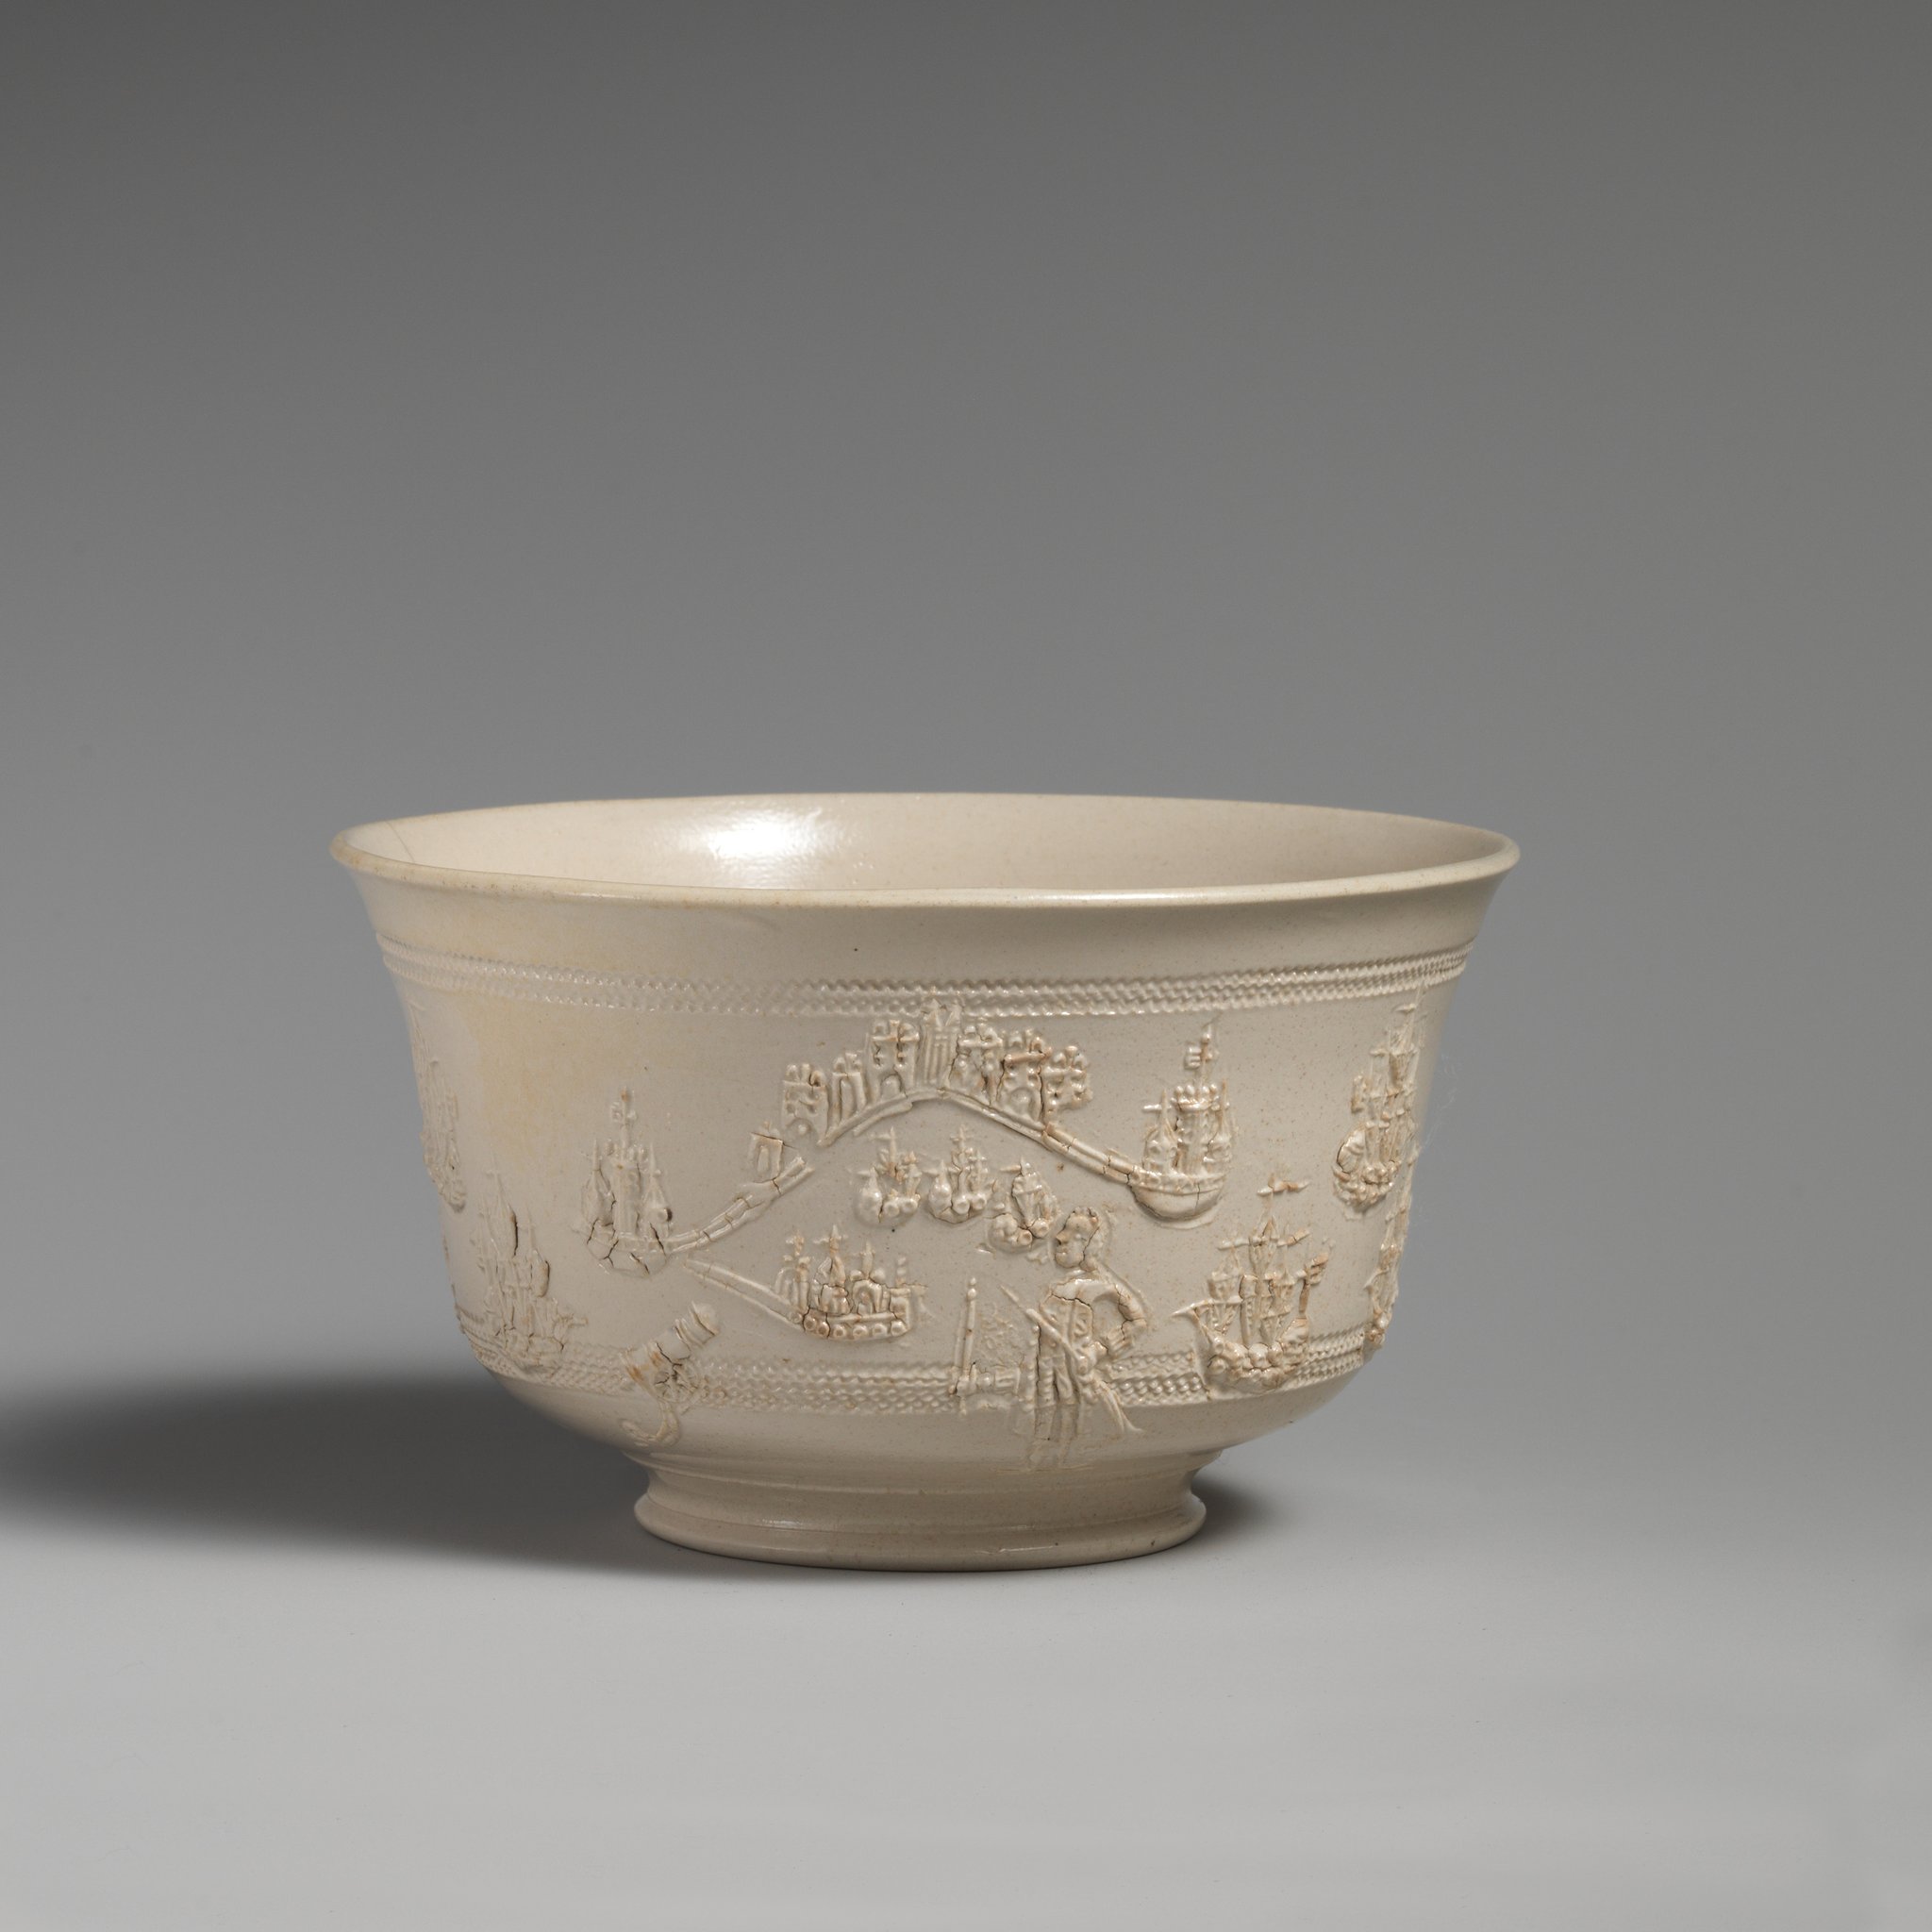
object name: bowl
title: Bowl with Admiral Edward Vernon (1684–1757) and the capture of Porto Bello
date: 1739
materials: stoneware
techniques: salt glaze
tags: ships